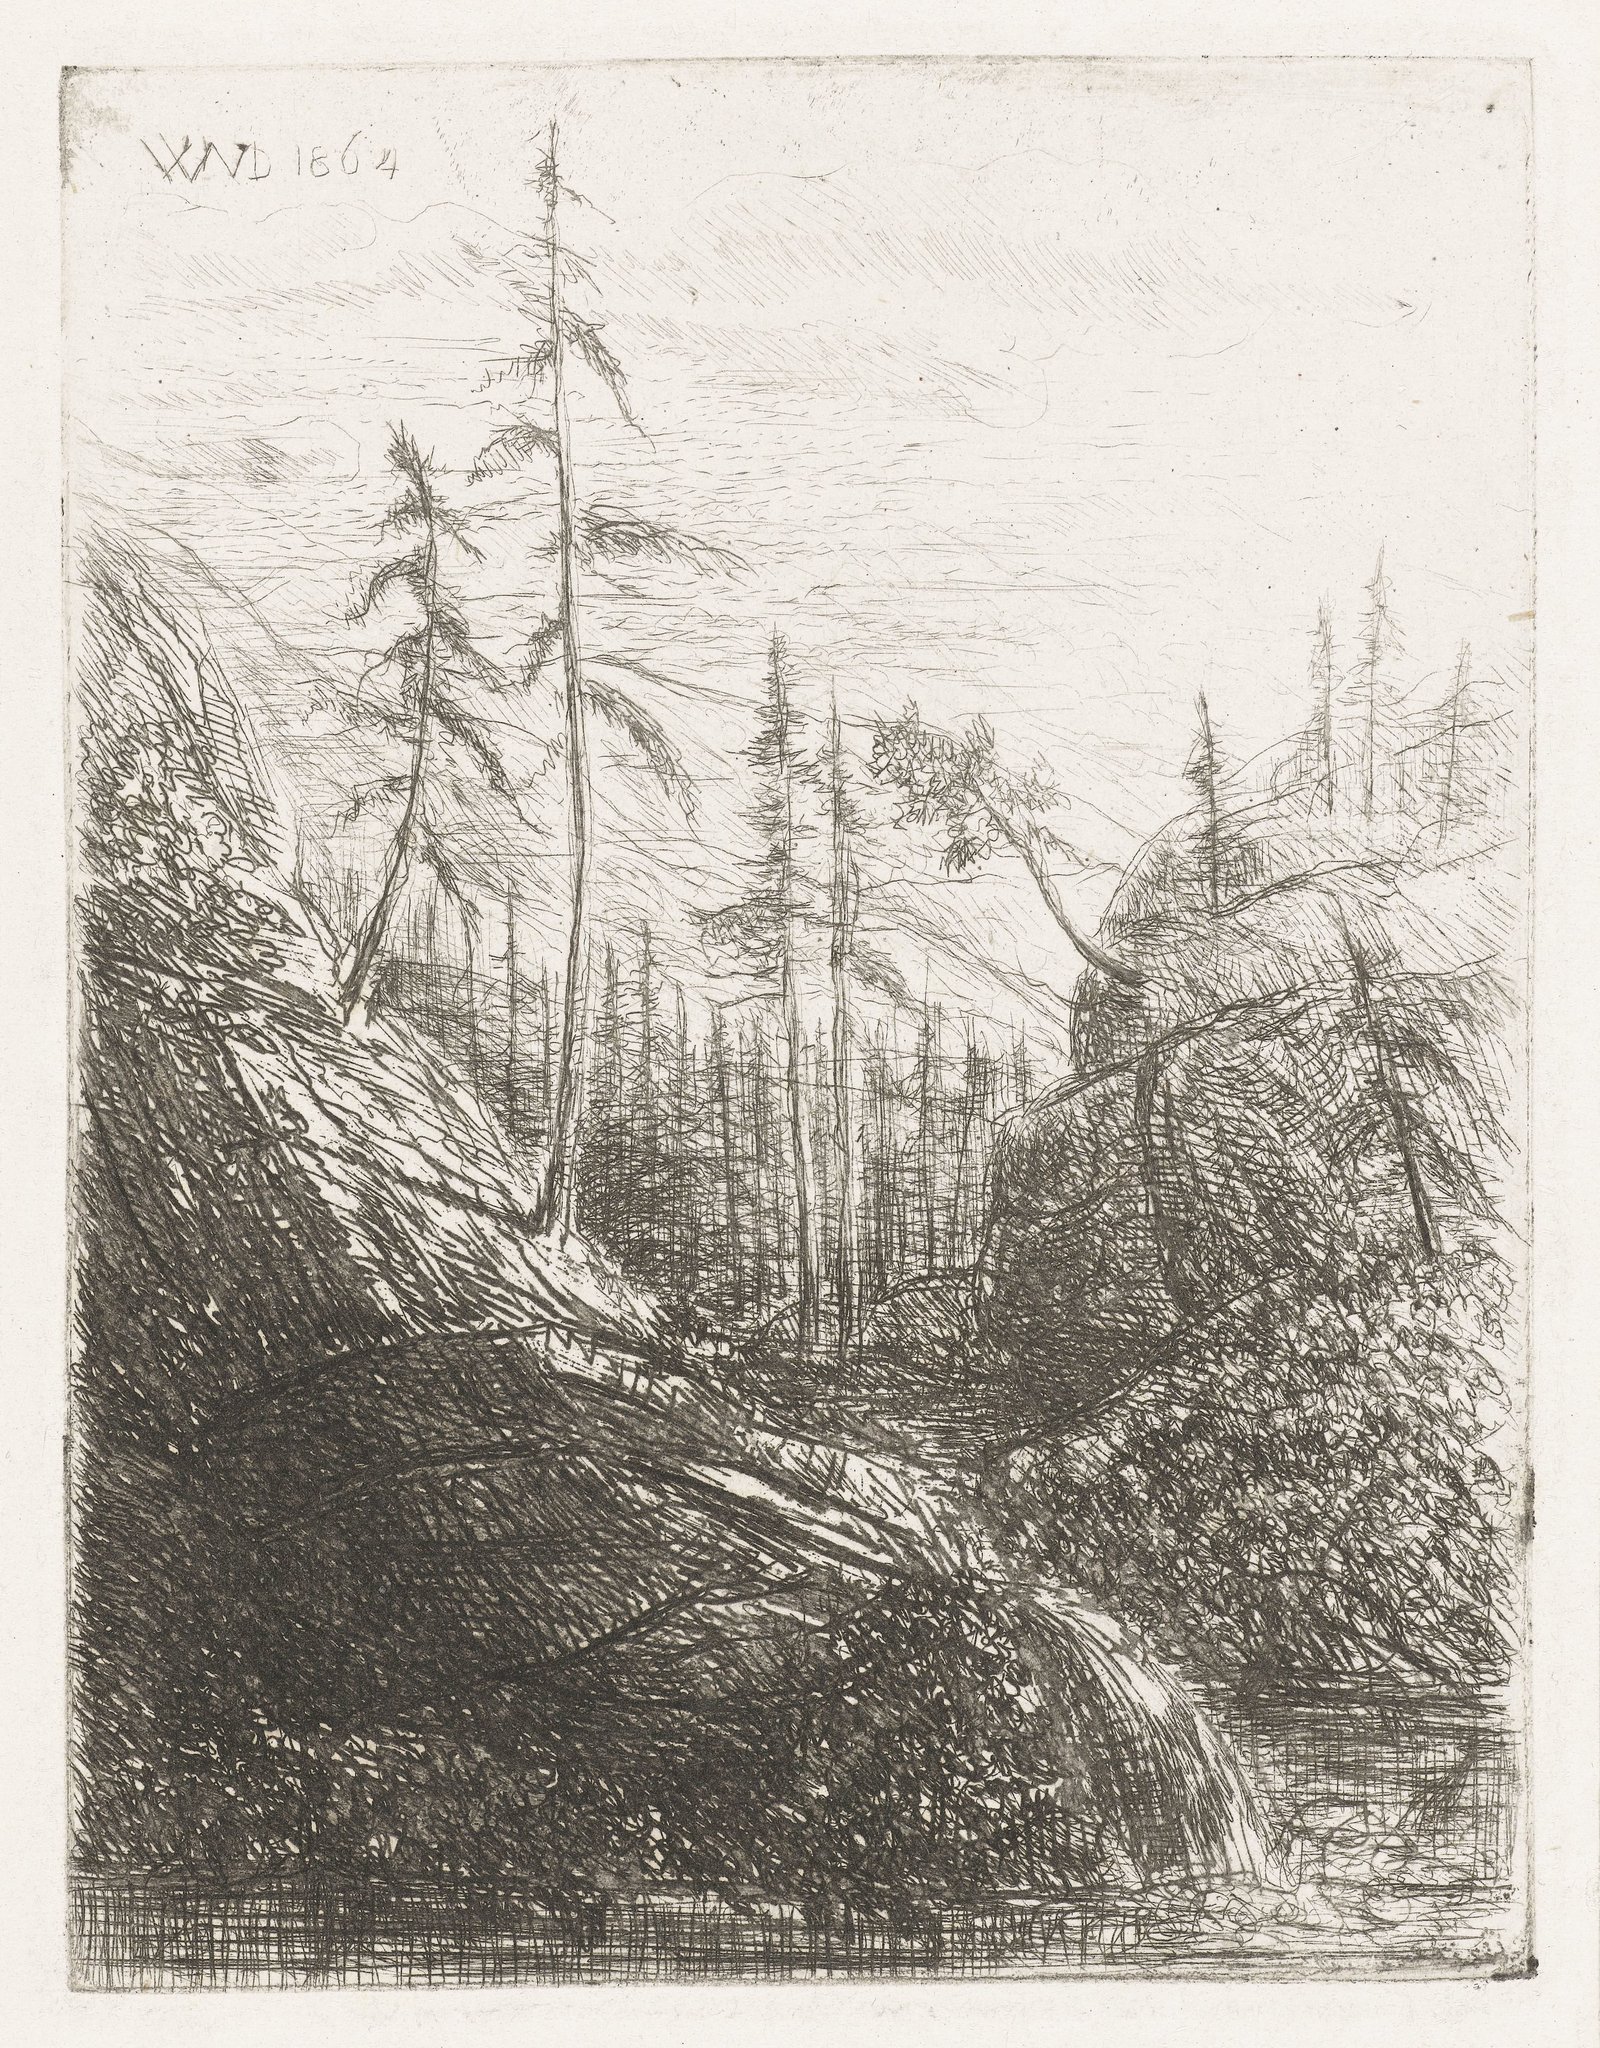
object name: print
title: Berglandschap met naaldbomen en beek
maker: willem matthias jan van dielen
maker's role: print maker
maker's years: 1805-1867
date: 1864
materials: paper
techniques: etching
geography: netherlands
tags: brook, mountains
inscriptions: collector's mark: Lugt 2228